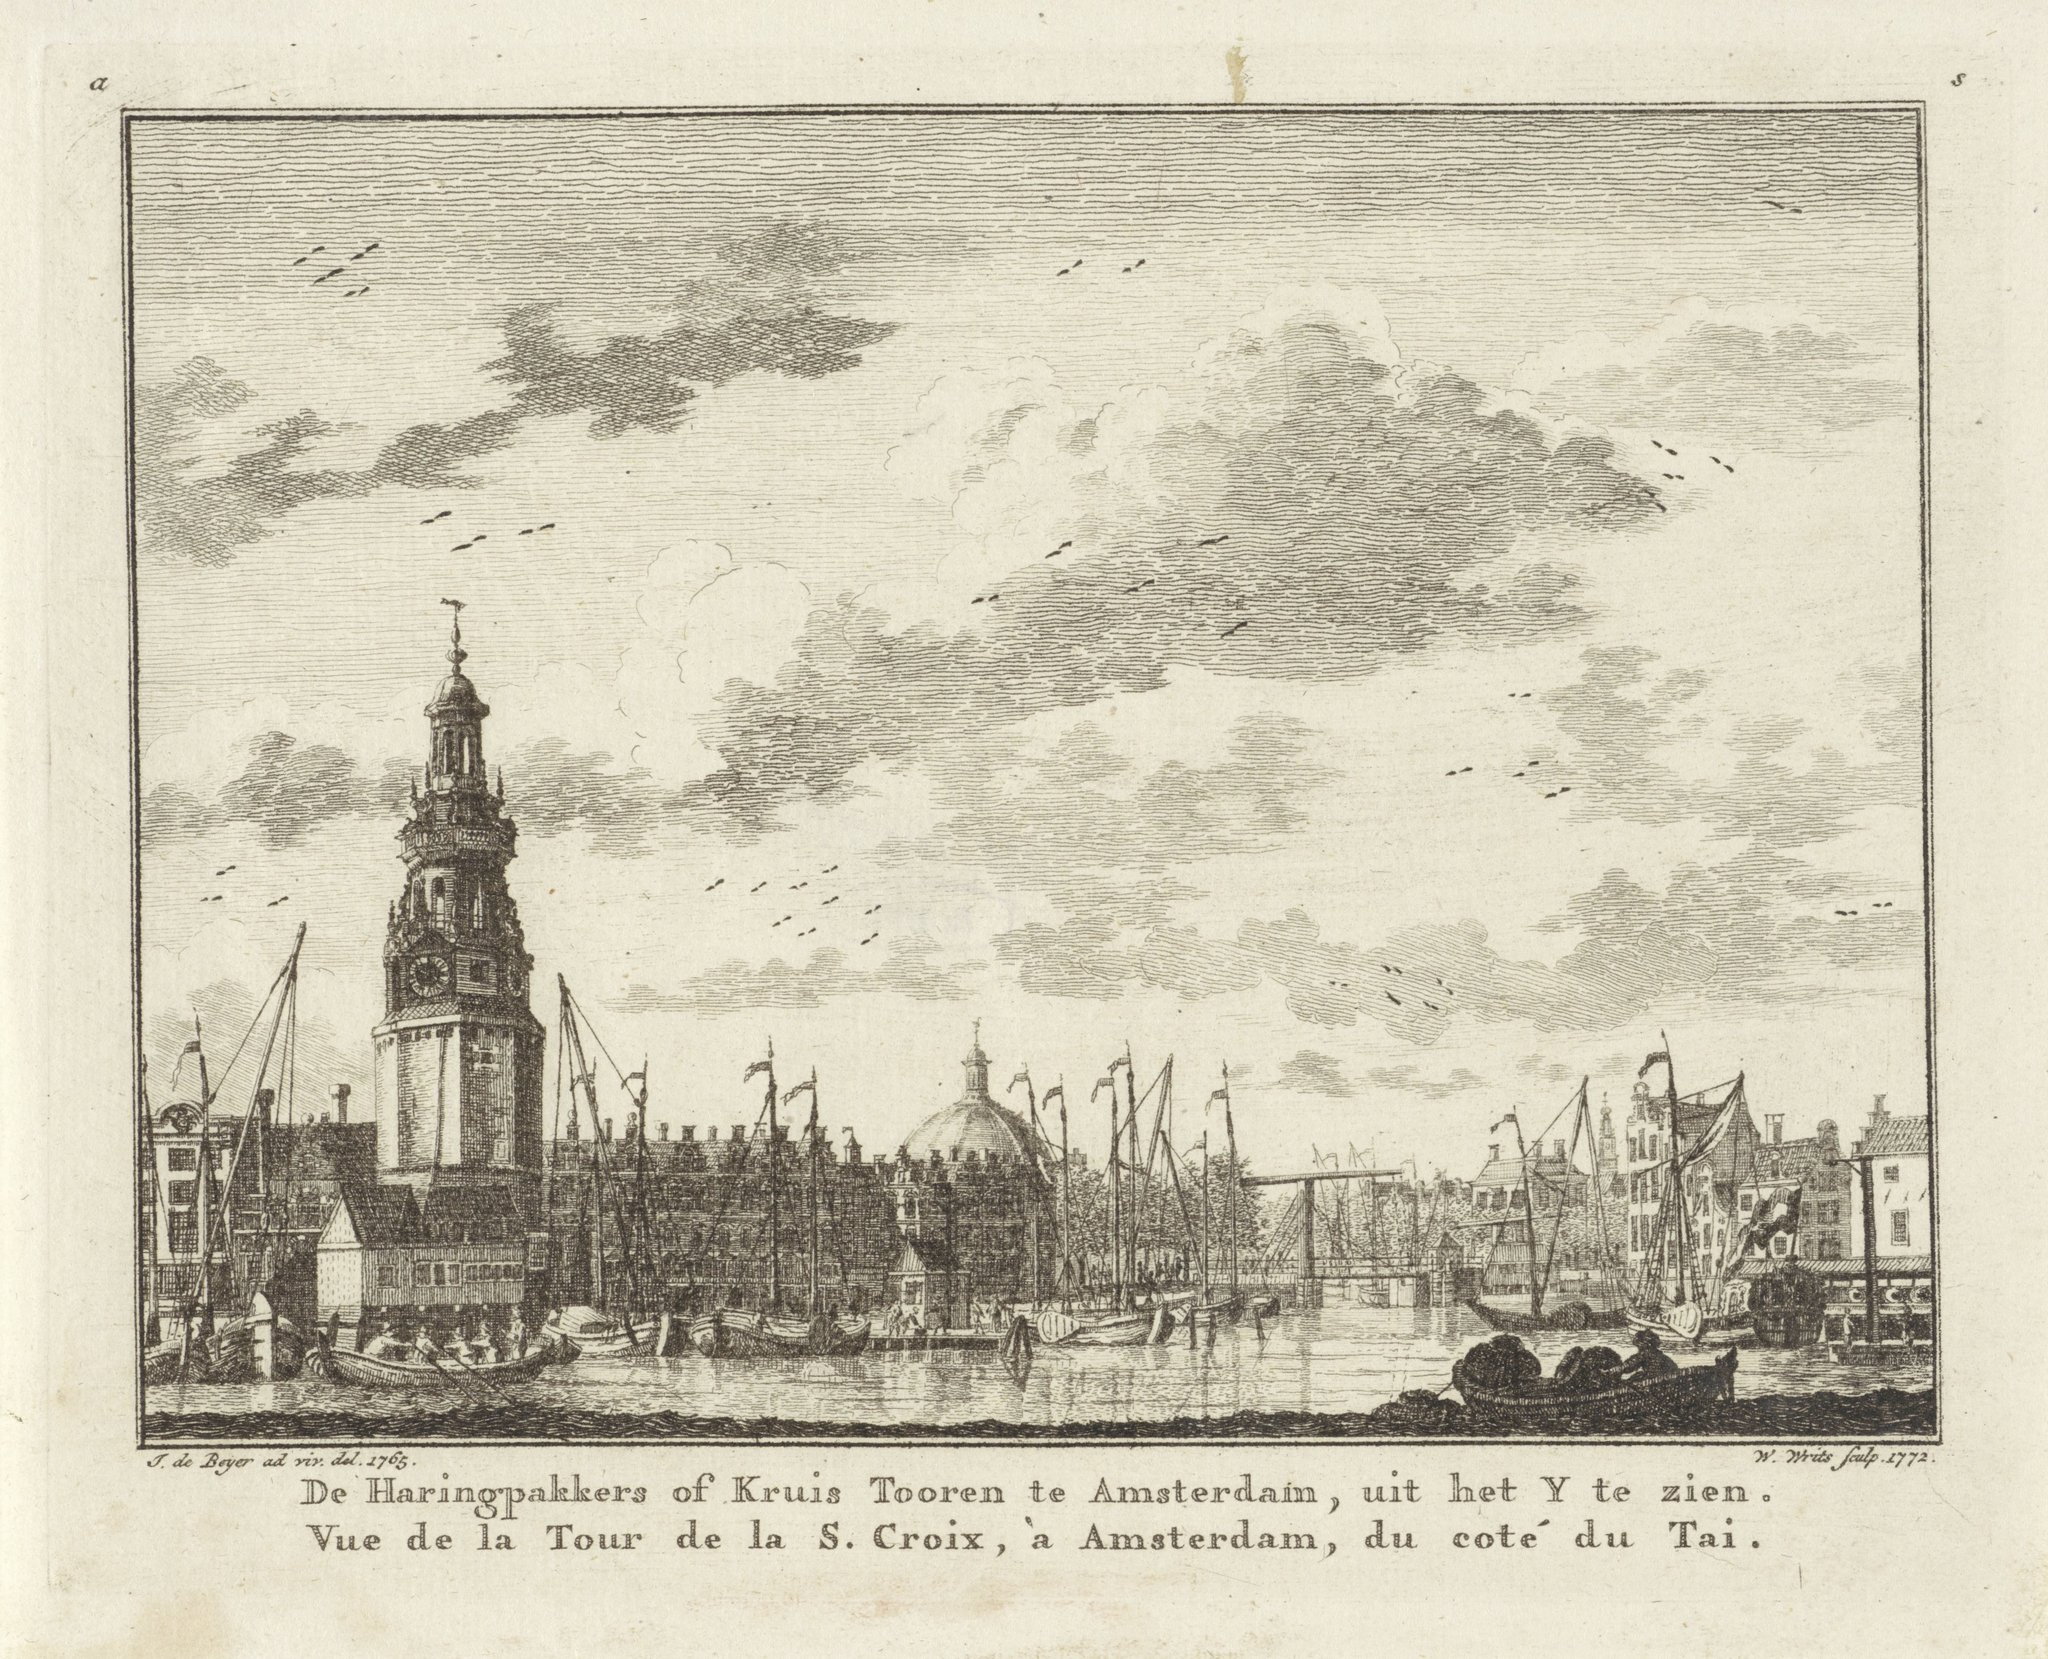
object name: print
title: De Haringpakkers of Kruis Tooren te Amsterdam, uit het Y te zien.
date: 1772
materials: paper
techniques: etching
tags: rowing-boat, canoe, etc.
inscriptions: collector's mark: Lugt 2228